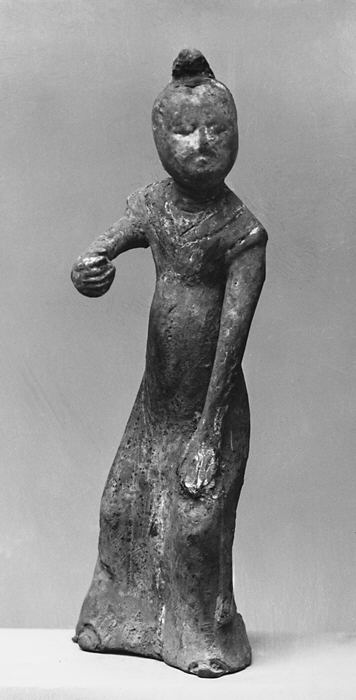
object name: figure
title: Female dancer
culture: chinese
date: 601-800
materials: earthenware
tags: human figures